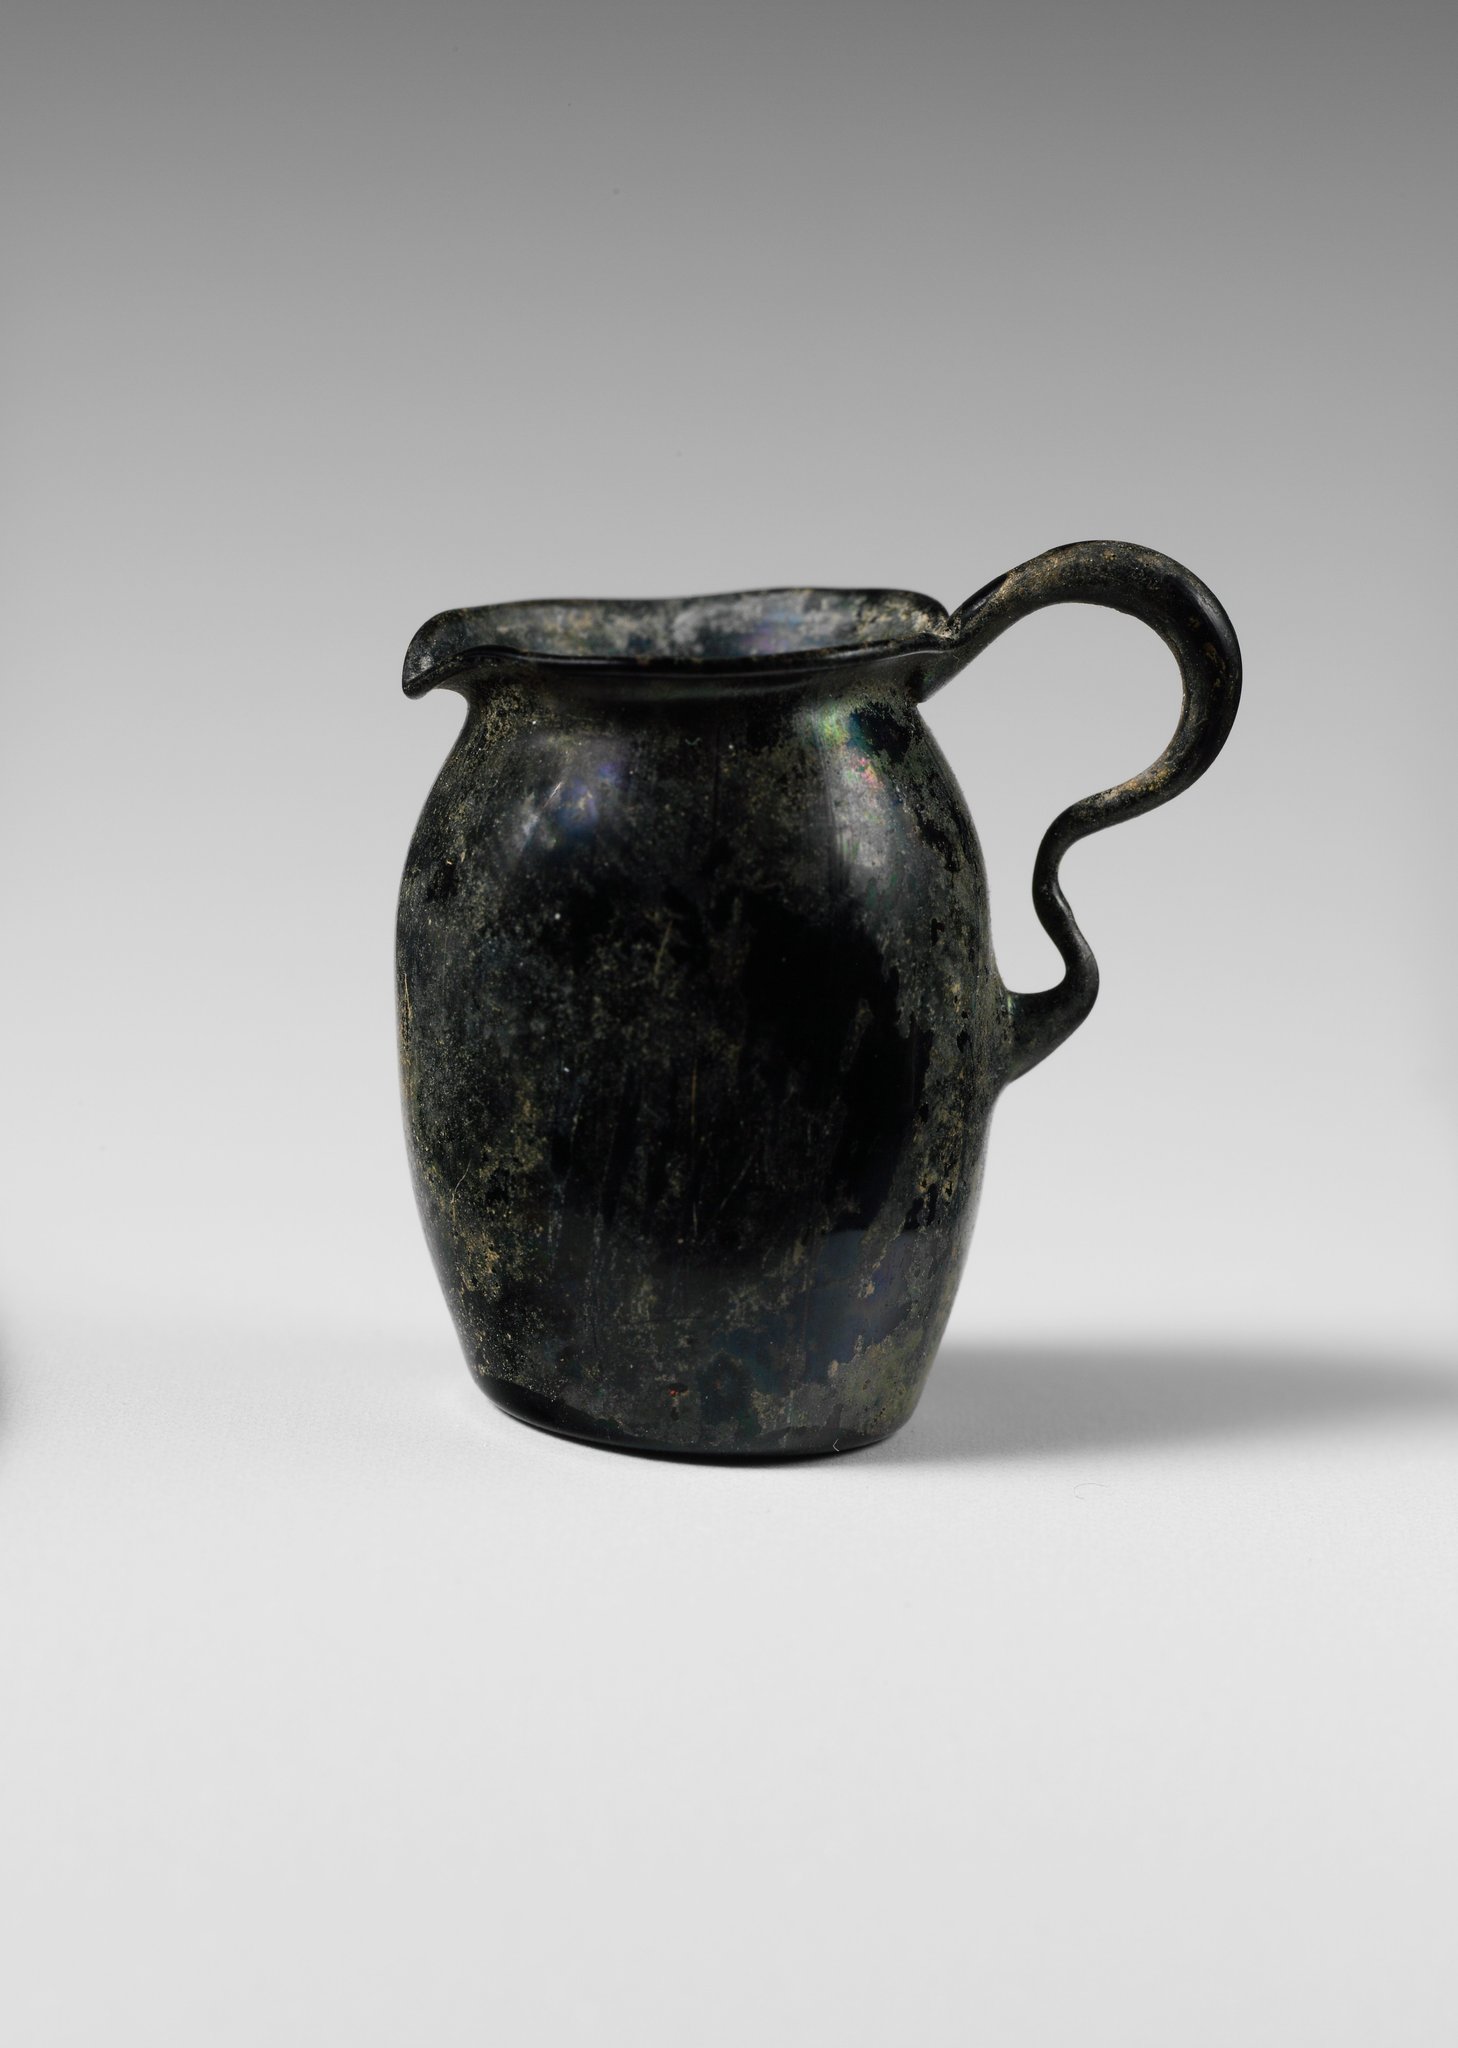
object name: jug, miniature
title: Glass miniature one-handled jug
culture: roman or later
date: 1-500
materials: glass